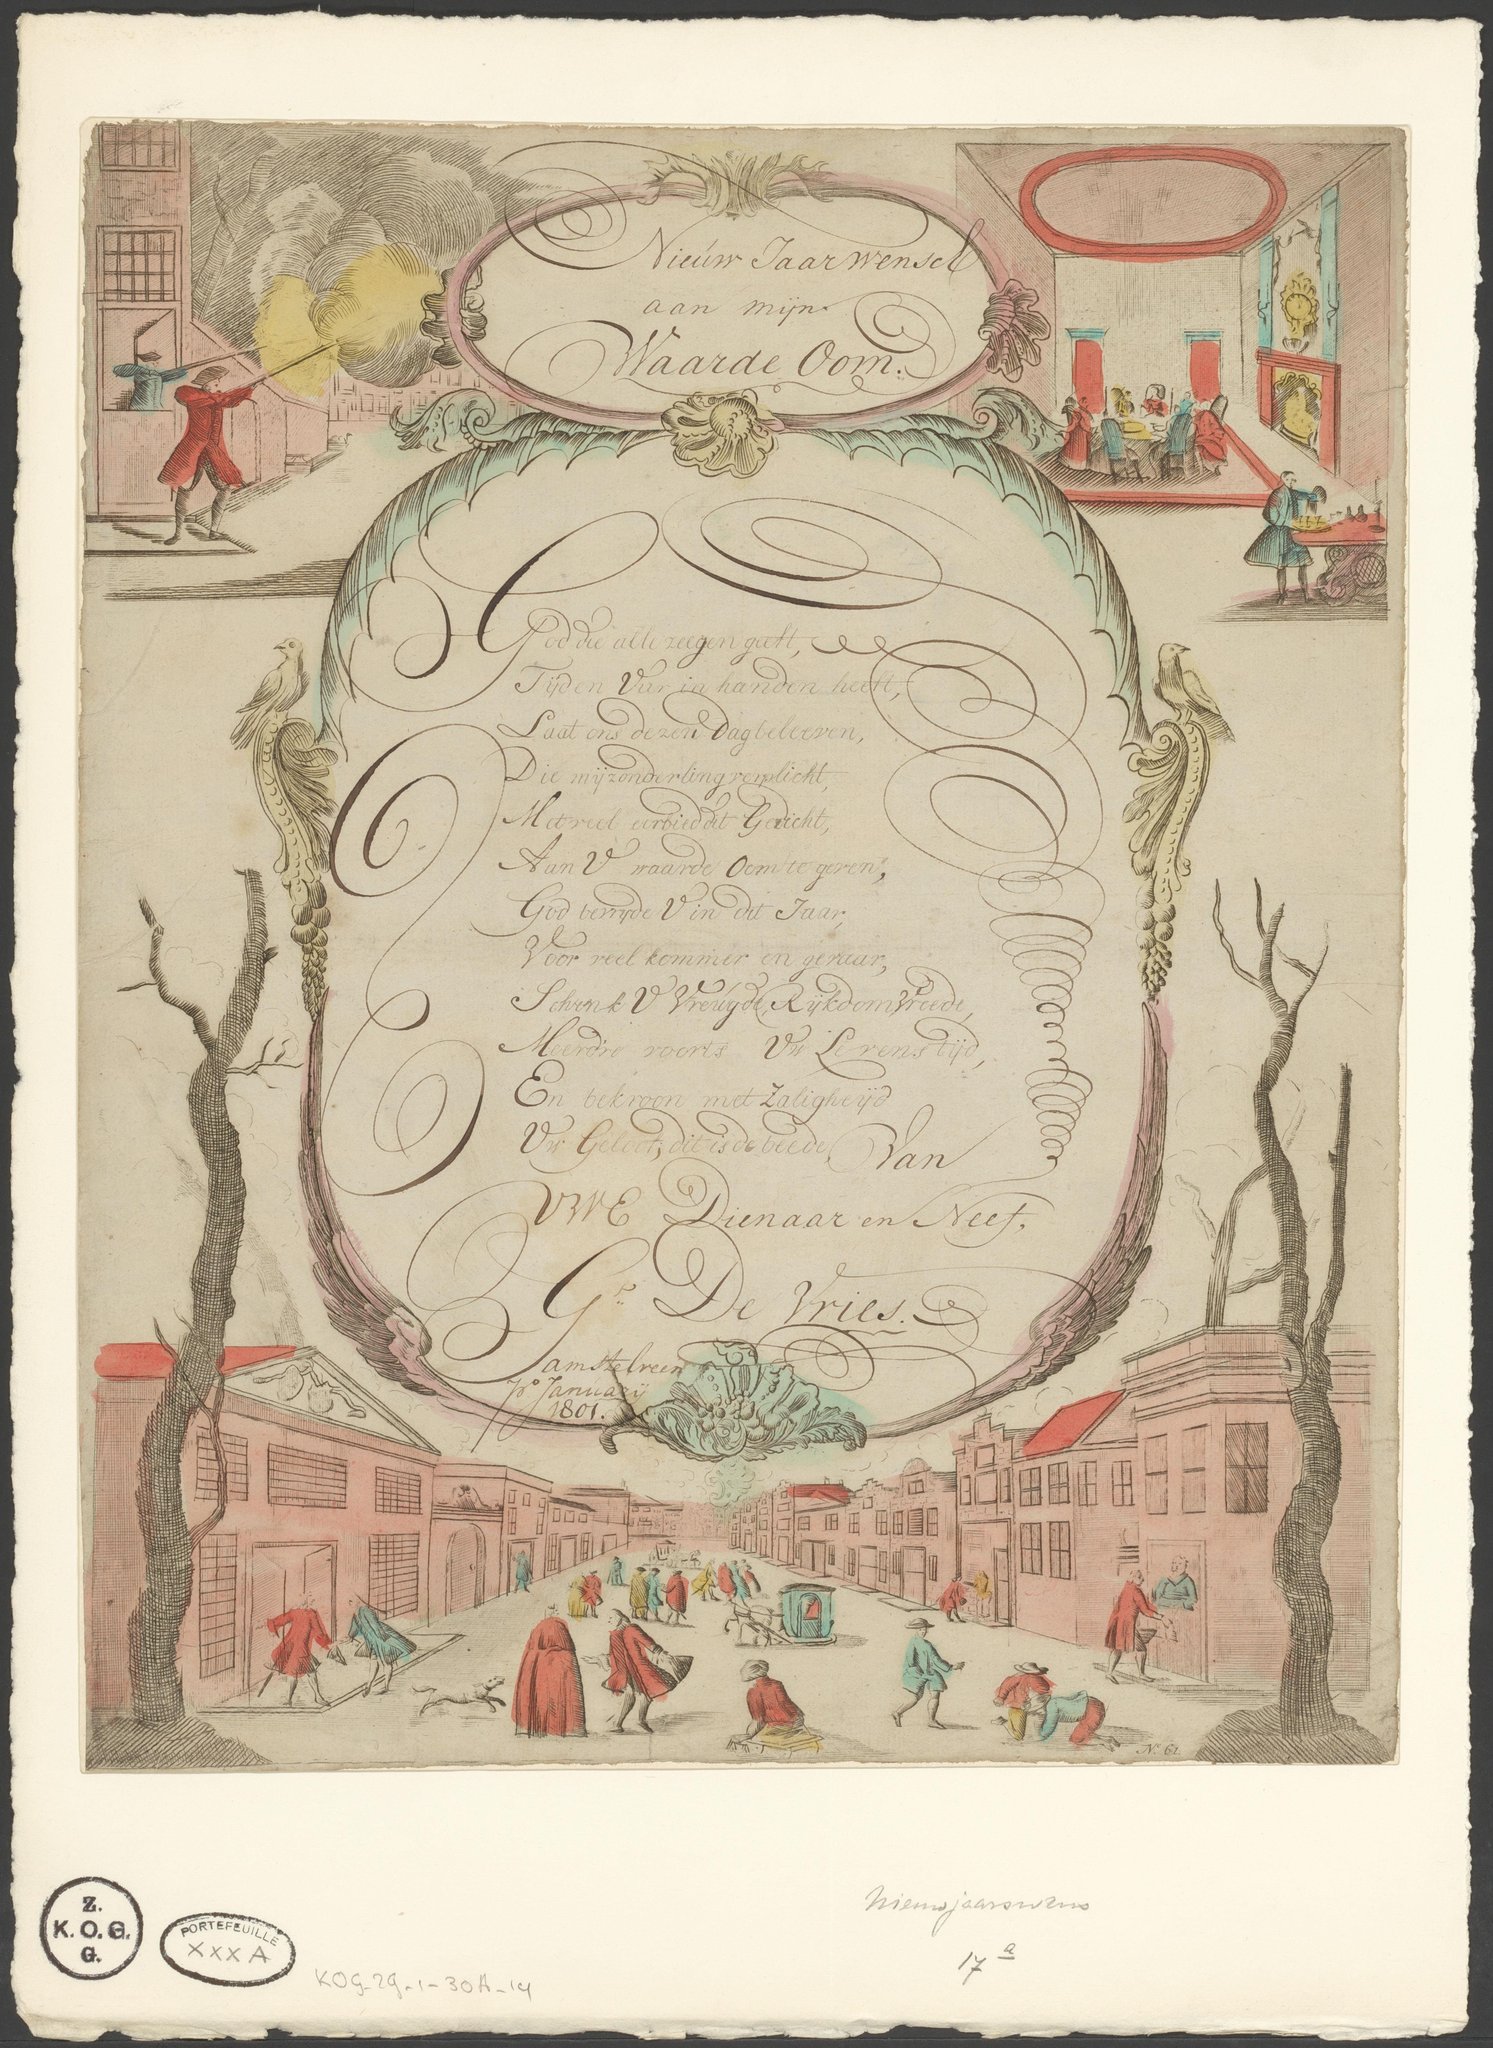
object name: print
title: Nieuwjaarswens van Gerrit de Vries, 1801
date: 1801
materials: ink, paper, watercolor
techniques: engraving, etching, hand coloring, writing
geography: amstelveen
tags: january 1 (~ festivities), family life at home, public road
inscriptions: collector's mark: Lugt 1641, collector's mark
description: Nieuwjaarswens van Gerrit de Vries, 1801. Gericht aan zijn oom. Handgeschreven vers binnen een voorgedrukte omlijsting met voorstellingen van schieten met geweren, de straat en binnenshuis. Rechtsonder genummerd: 61. Onderwerpsrubrieken binnen de Atlas Zeden en Gewoonten: Nieuwjaars- en kermiswenschen.